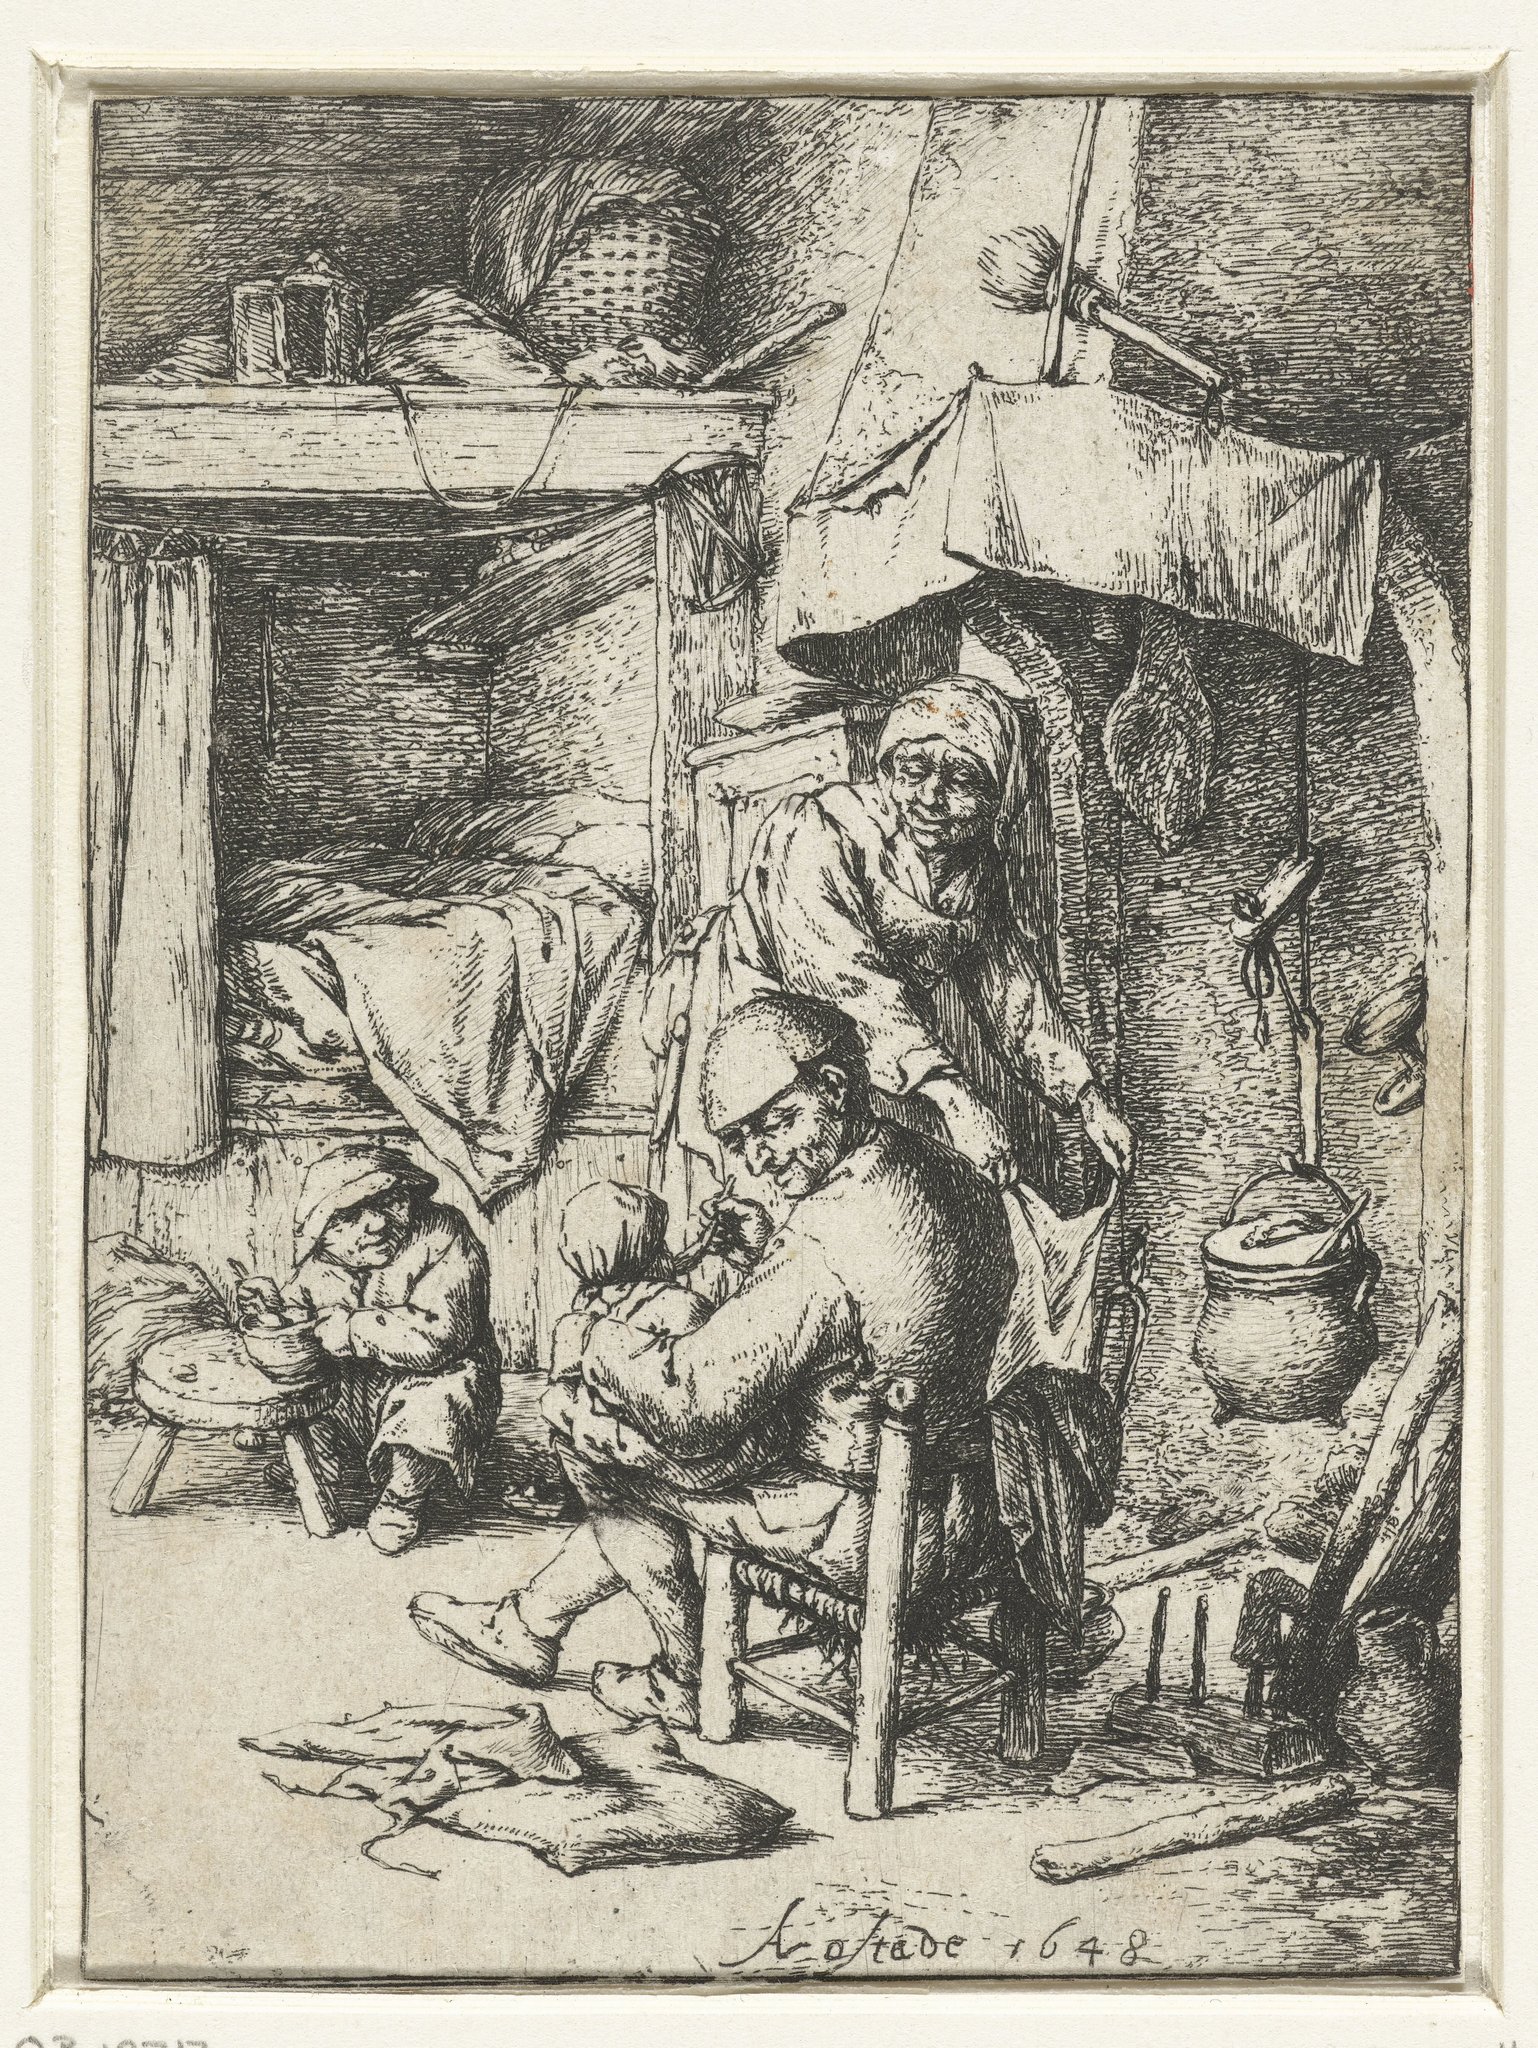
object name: print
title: De huisvader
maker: adriaen van ostade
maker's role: draughtsman, painter, print maker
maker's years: 1610-1685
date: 1648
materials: paper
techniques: drypoint, etching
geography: haarlem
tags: (family) meal, father and child(ren), man and child(ren) (family group)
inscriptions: collector's mark: Lugt 240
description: Een vader geeft een klein kind op zijn schoot te eten, de moeder staat bij de haard waar een pot boven het vuur hangt. Een klein kind zit op de grond bij een kruk te eten. Dit boeren gezin is gesitueerd in een armoedig interieur met verschillende huishoudelijke attributen en op de achtergrond een bedstee.